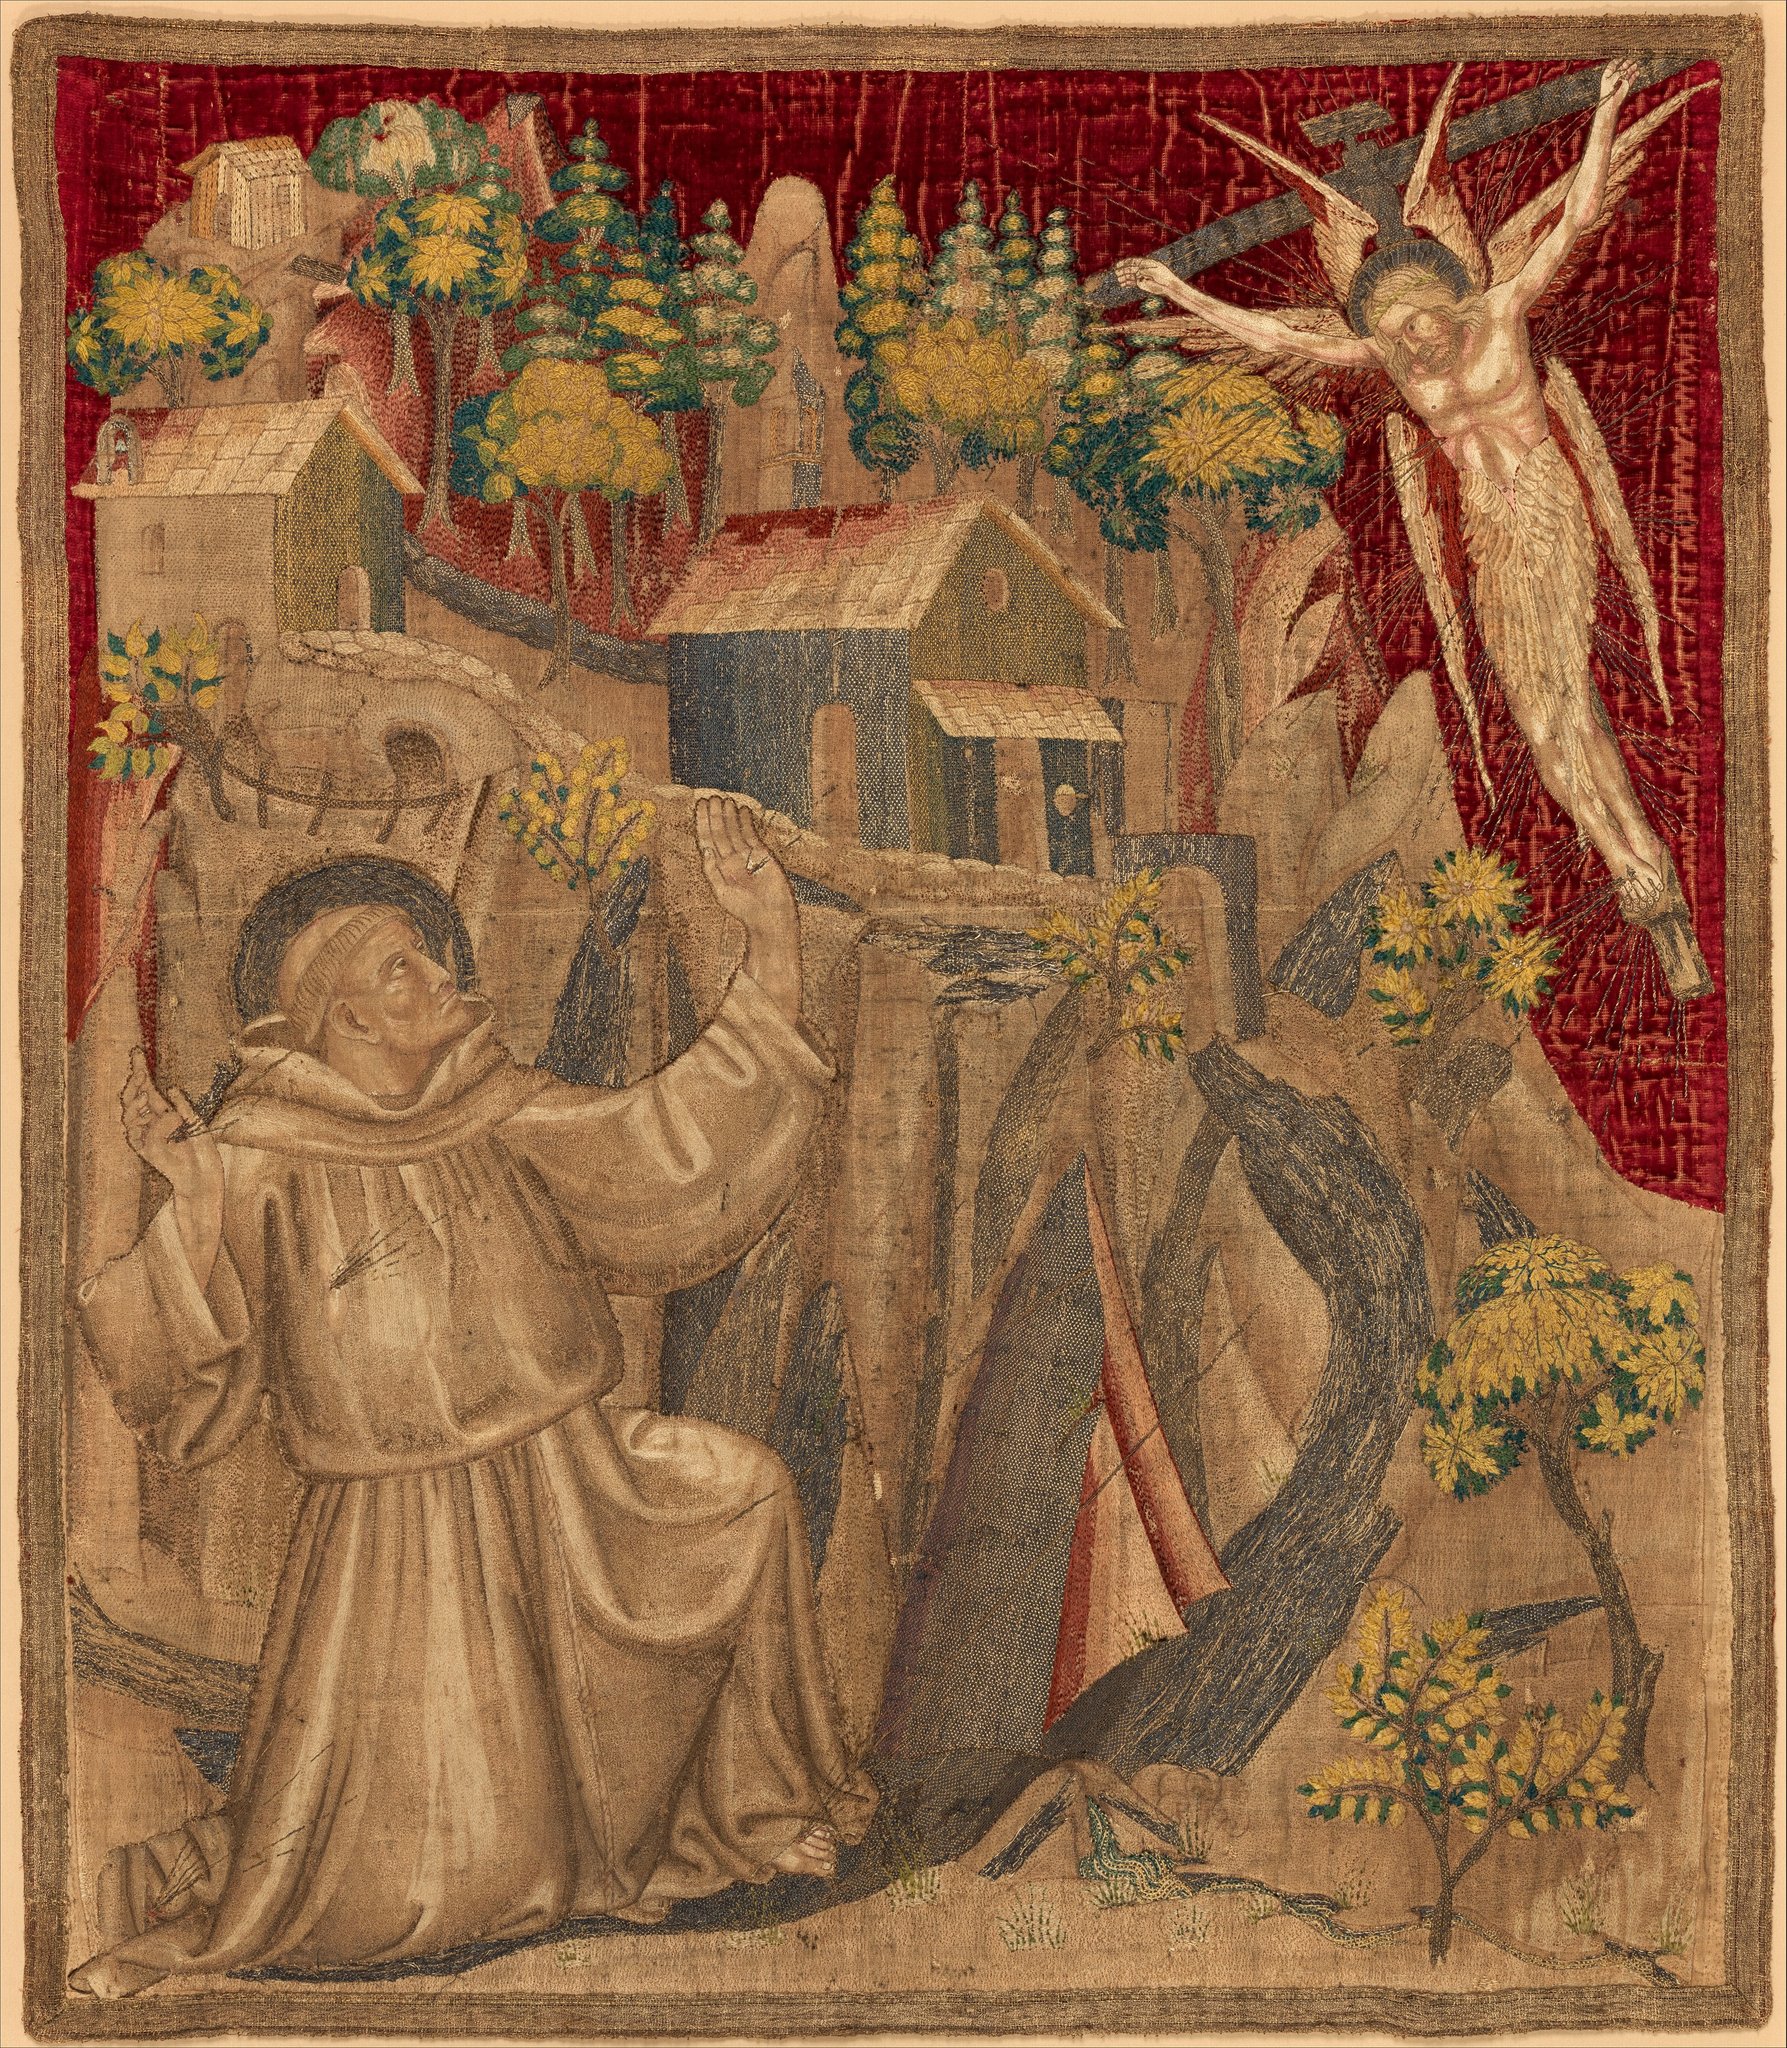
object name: textile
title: Textile with Saint Francis Receiving the Stigmata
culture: italian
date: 1367-1400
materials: metal thread, silk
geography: italy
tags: angels,saint francis